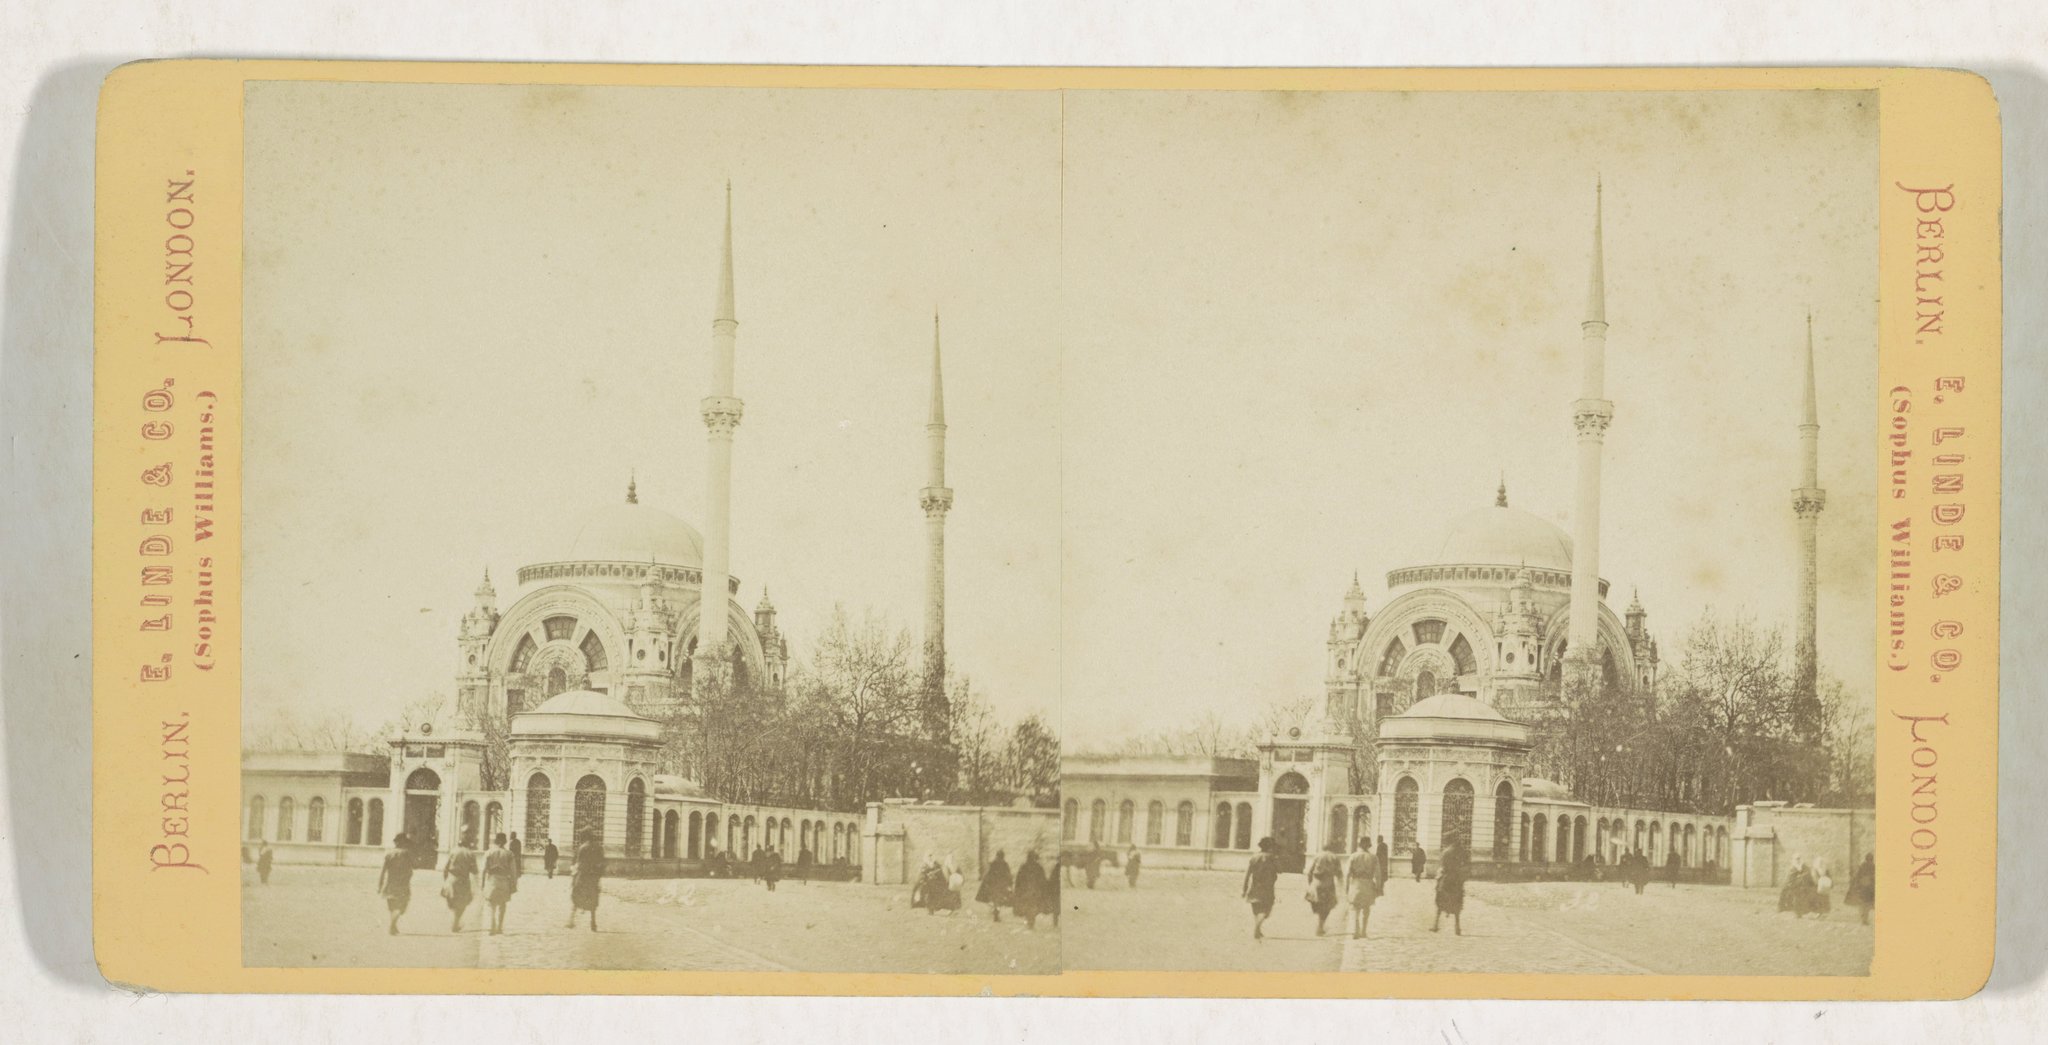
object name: stereograph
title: Moschee Valide in Dolma-Bagtche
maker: Anonymous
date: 1873-1890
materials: cardboard, paper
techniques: albumen print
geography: berlin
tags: temple, shrine ~ islam, mohammedanism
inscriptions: number: ‘32’